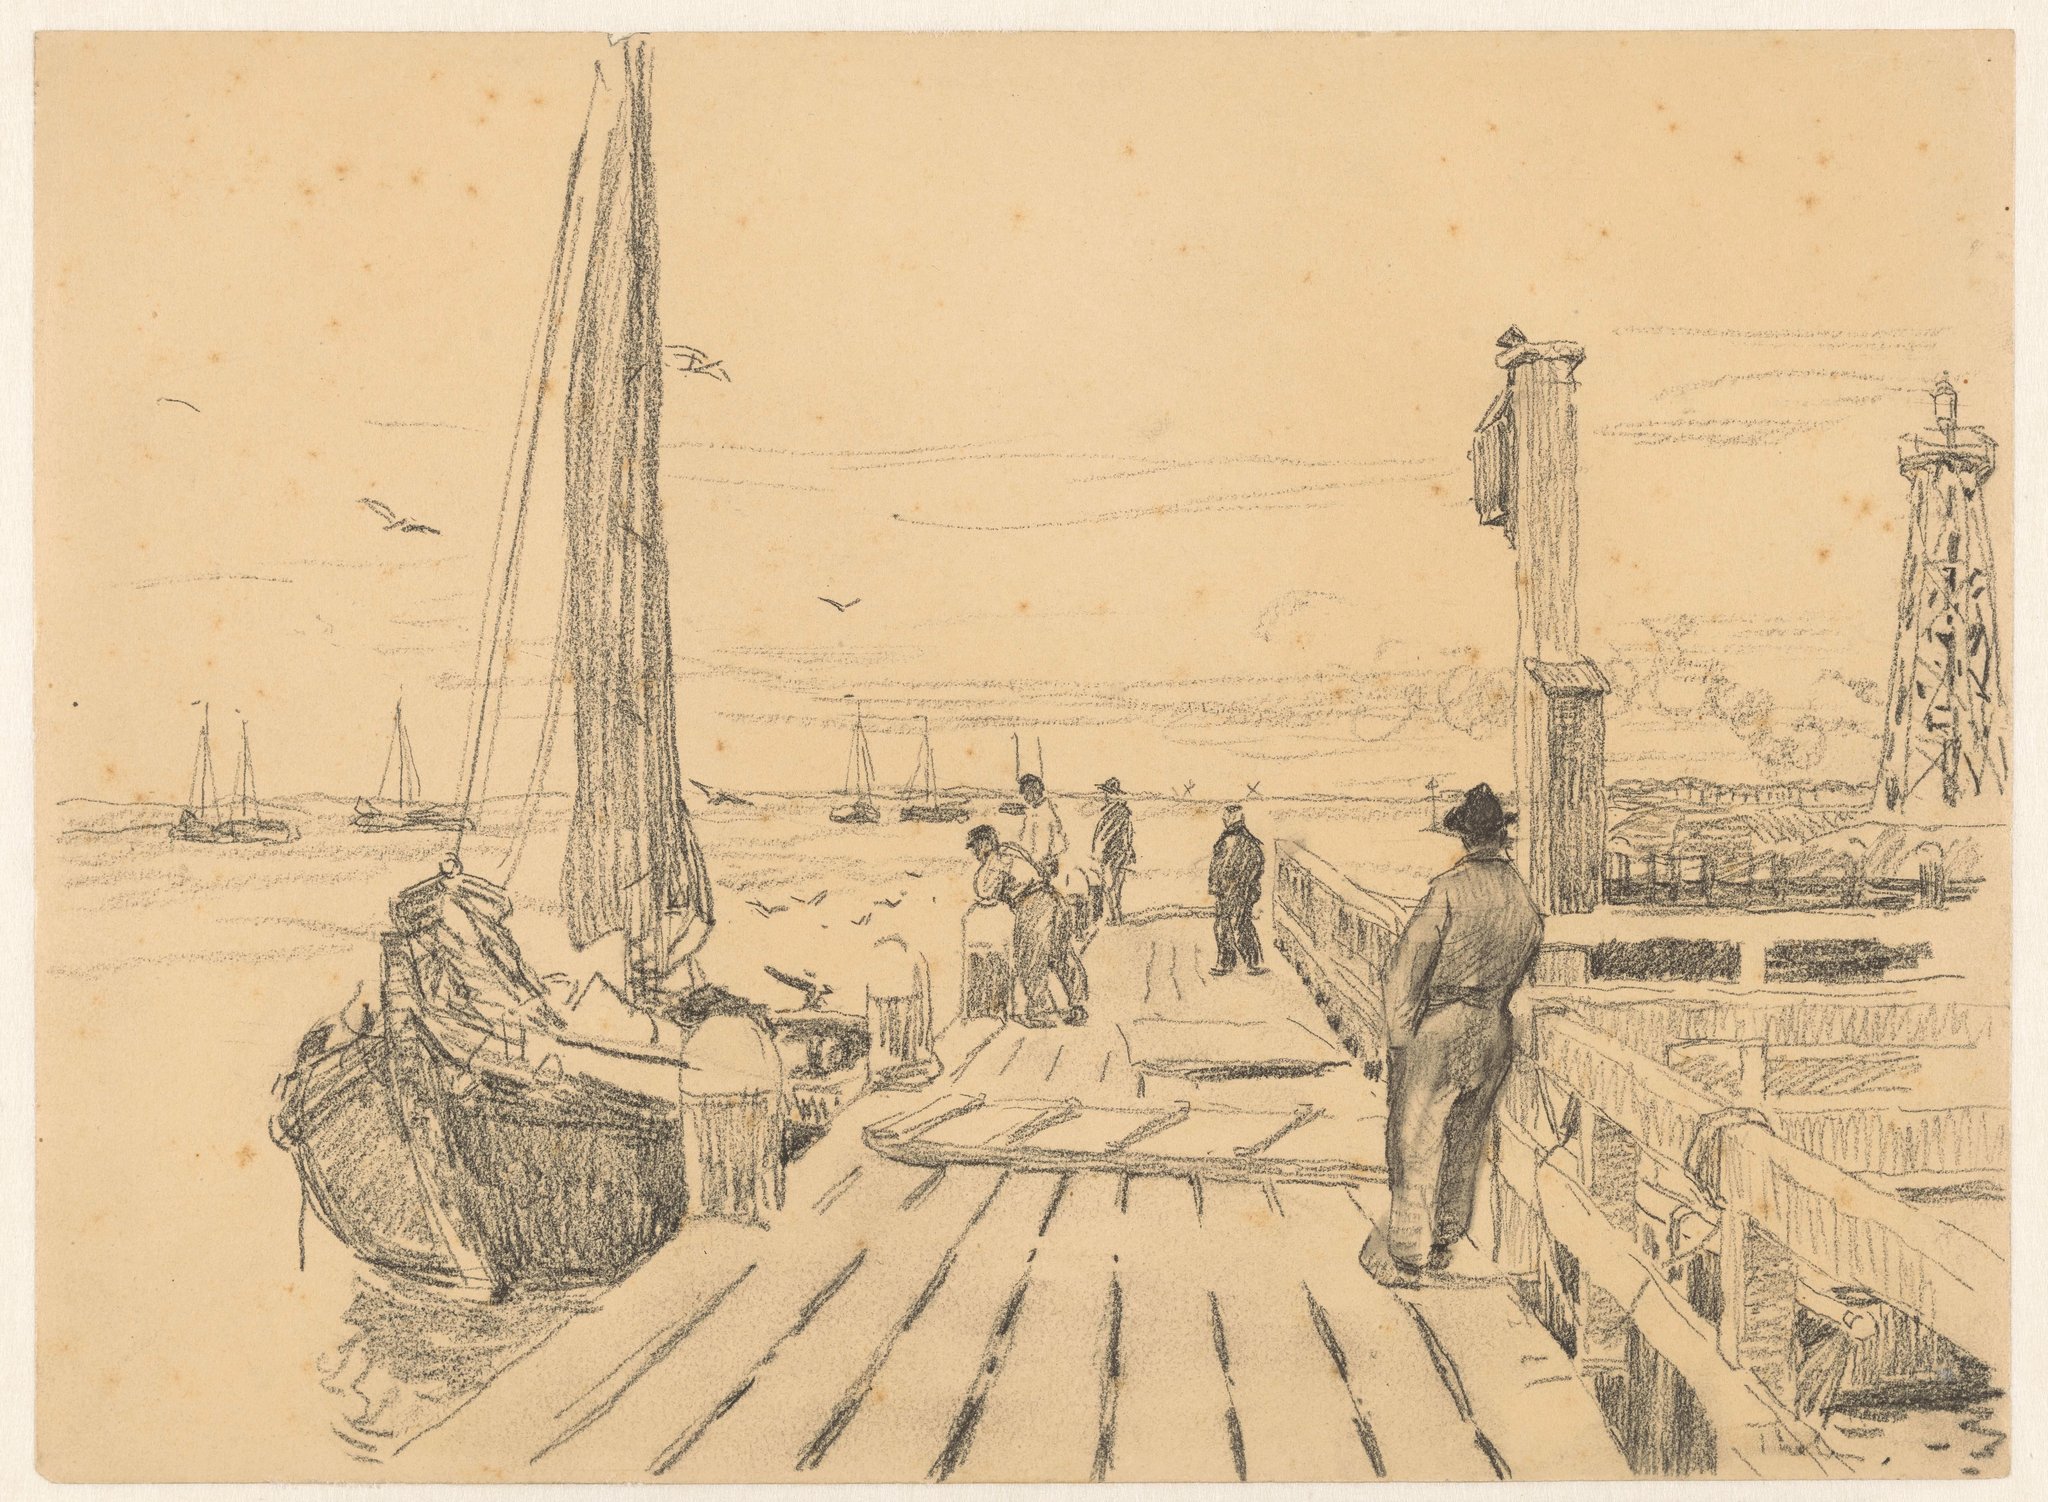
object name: drawing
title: Steiger met diverse personen en een aangemeerde boot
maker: willem bastiaan tholen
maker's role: draughtsman, painter, print maker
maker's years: 1860-1931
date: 1870-1931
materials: chalk, paper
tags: ships (in general), pier, quay, wharf